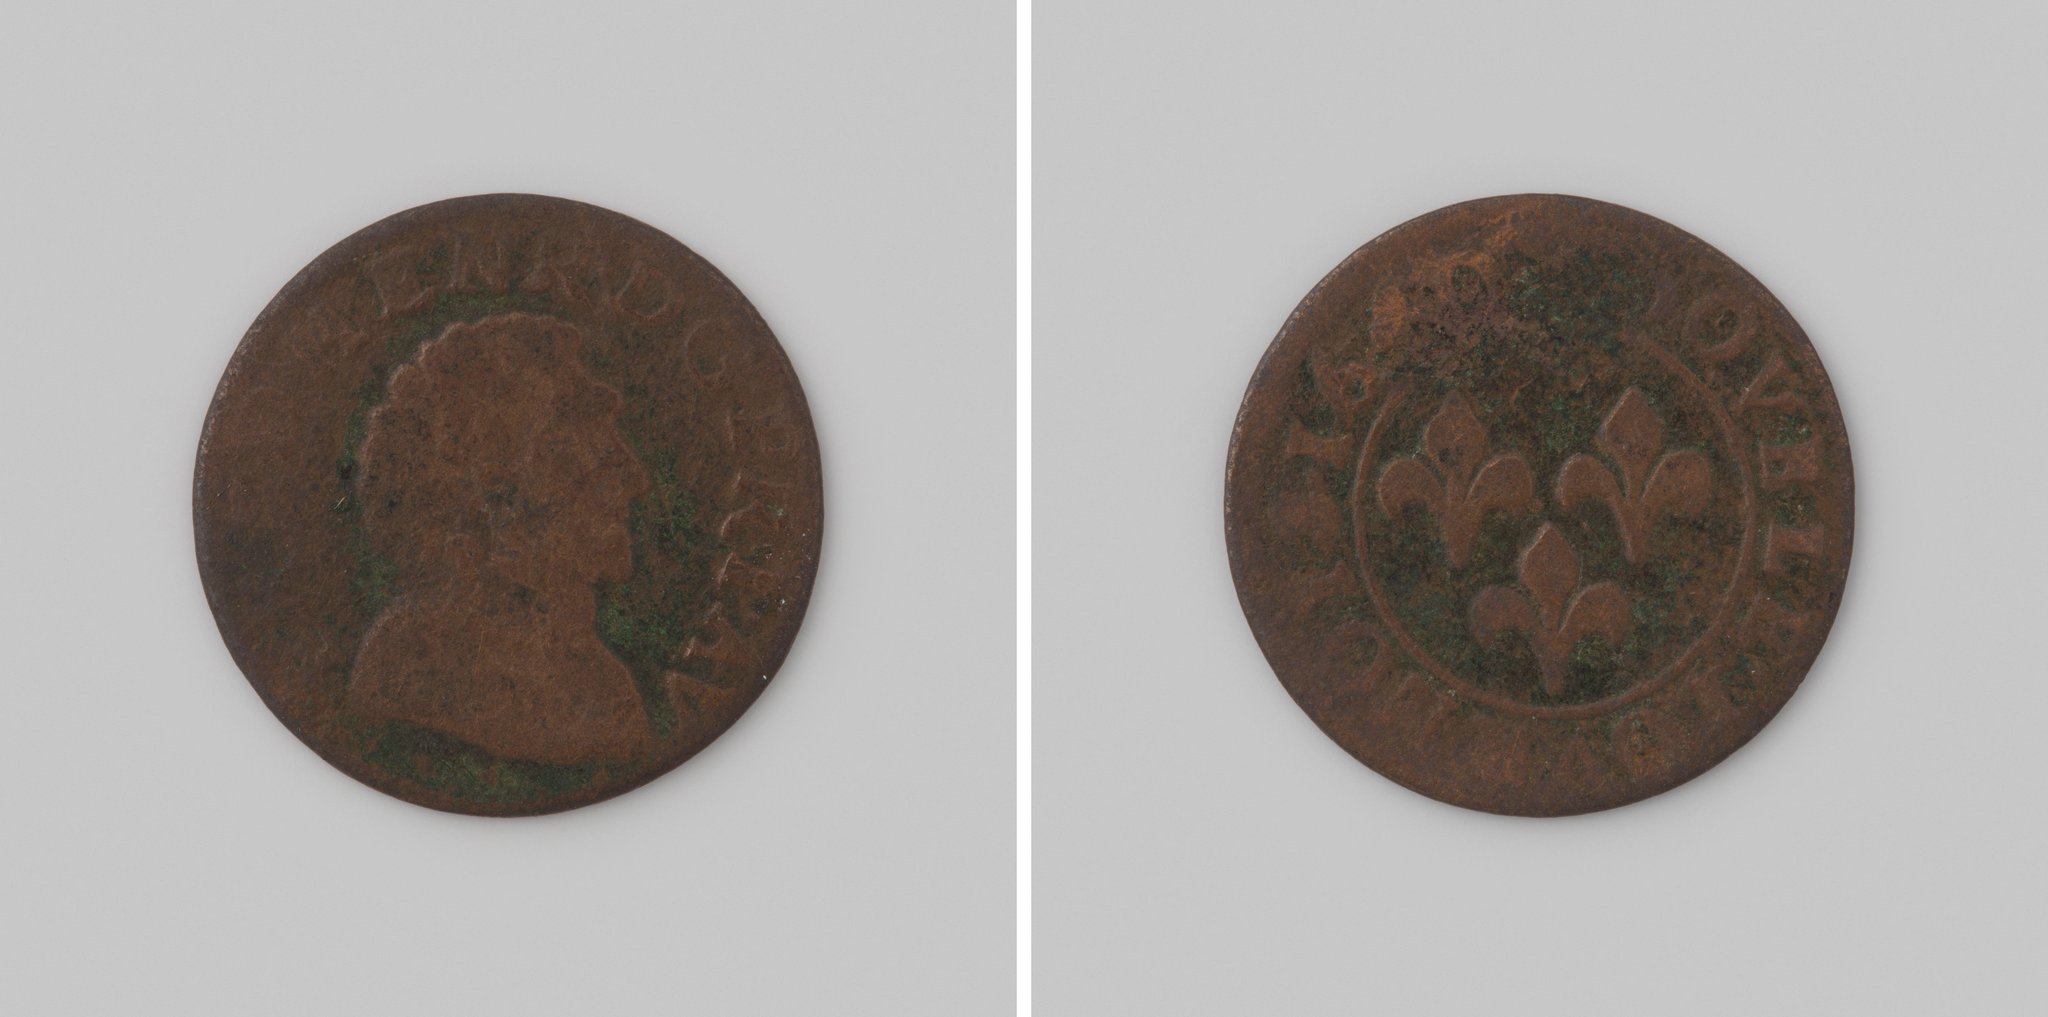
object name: coin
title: Prinsdom Orange, double, Frederik Hendrik, 1625-1647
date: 1625-1647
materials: copper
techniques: striking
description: Koperen munt. Voorzijde: portret van de prins naar rechts. Keerzijde: wapen, bestaande uit drie lelies in twee regels.